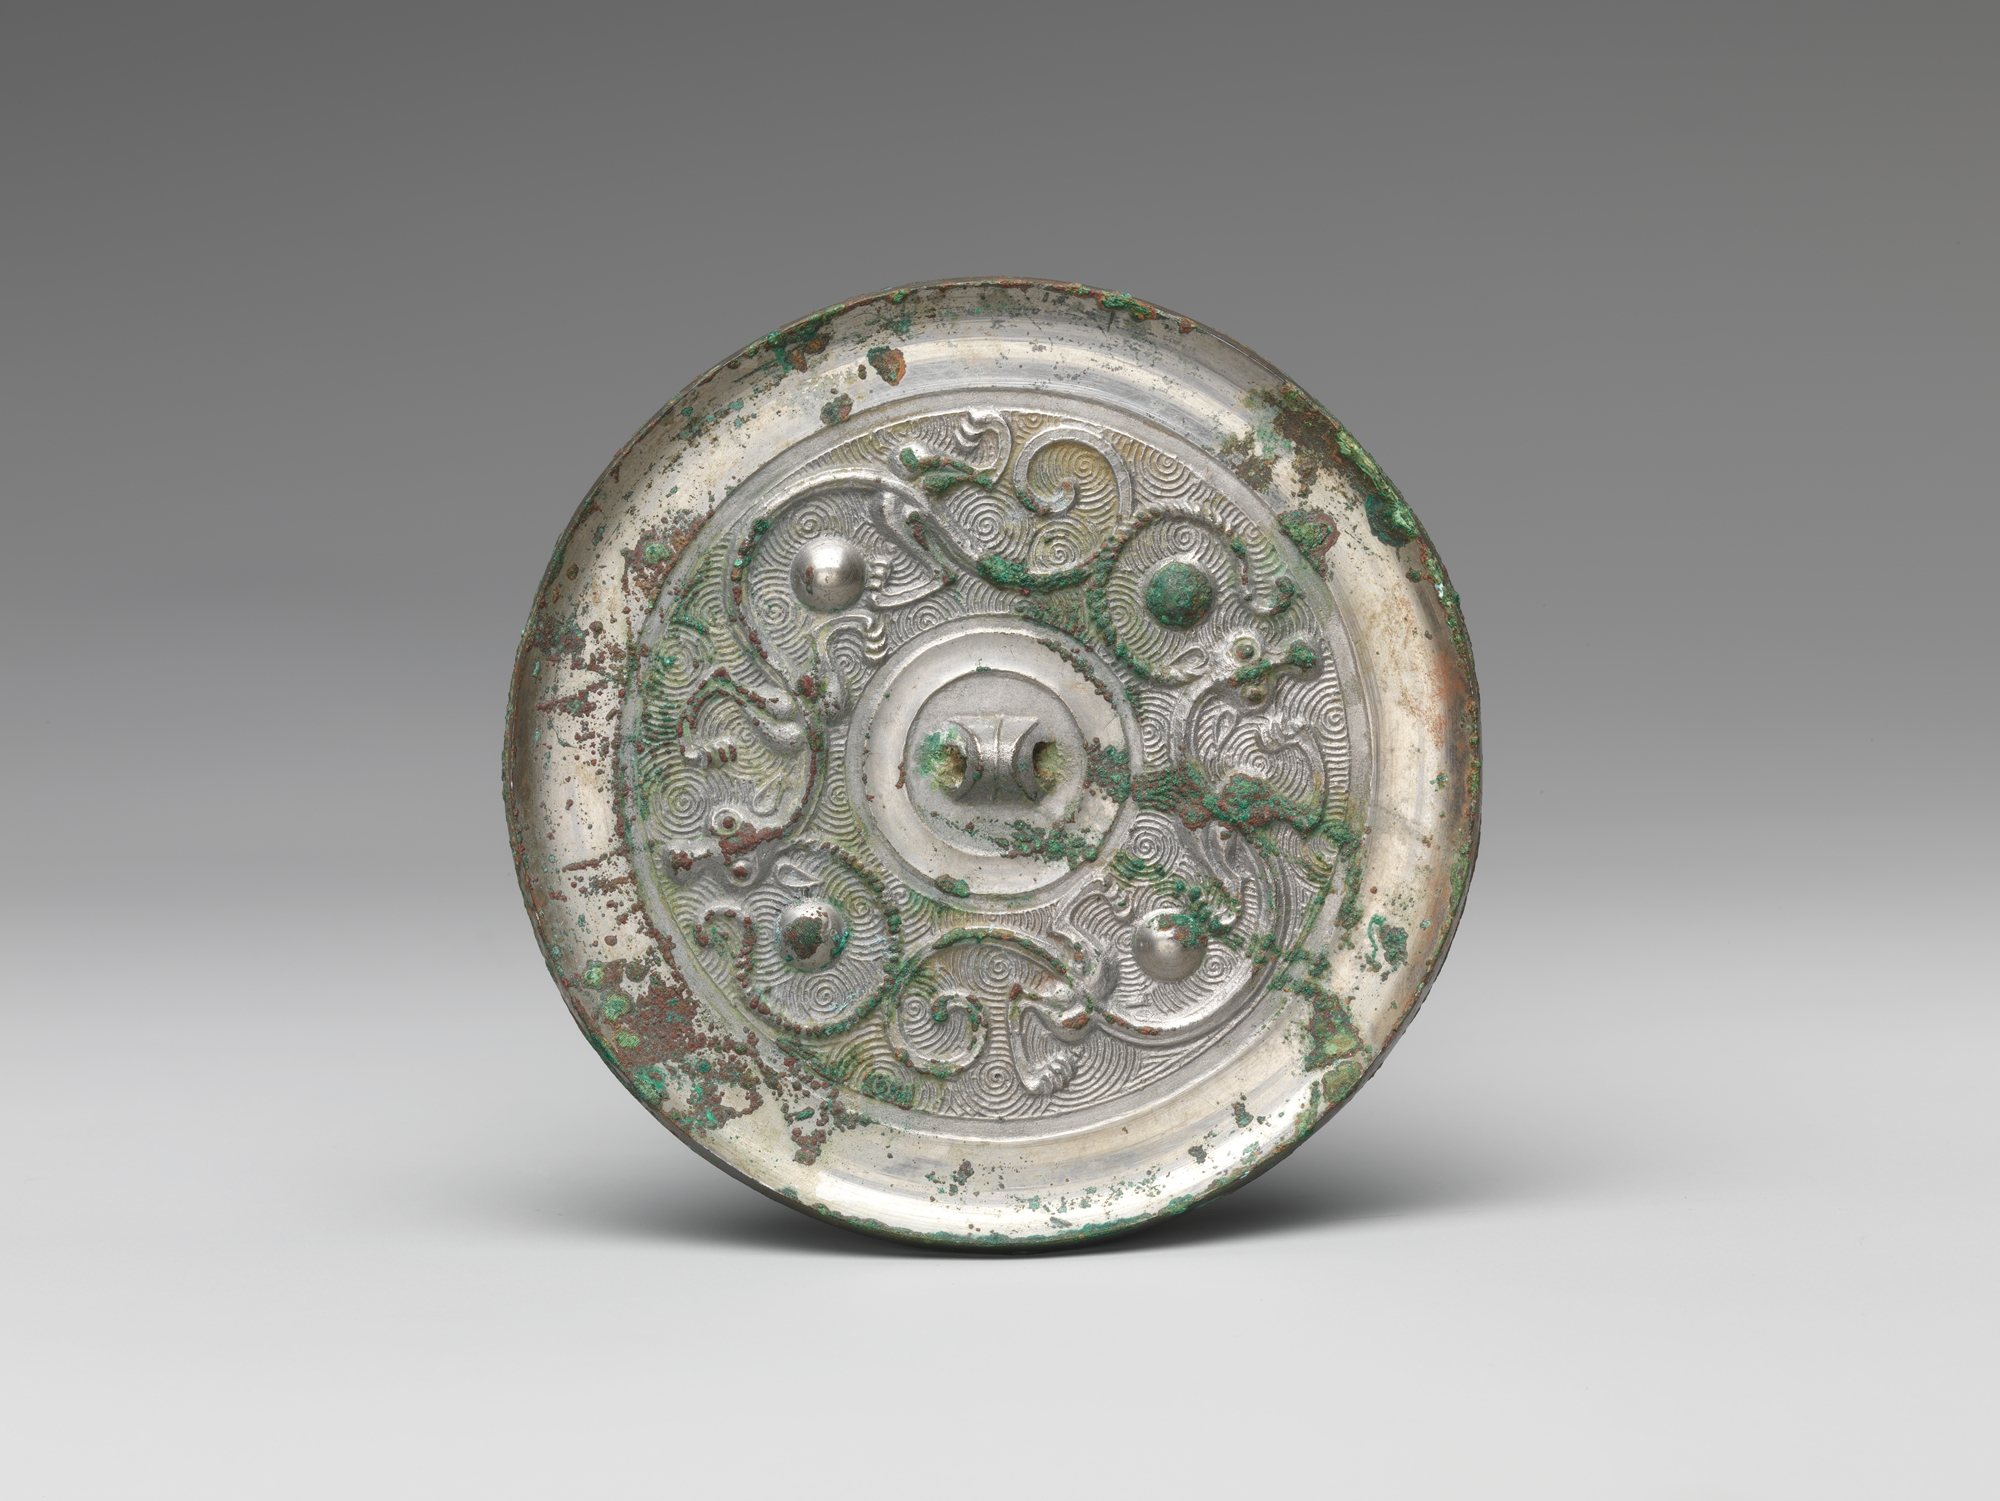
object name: mirror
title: Mirror with two dragons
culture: chinese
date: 200-101 BCE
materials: bronze